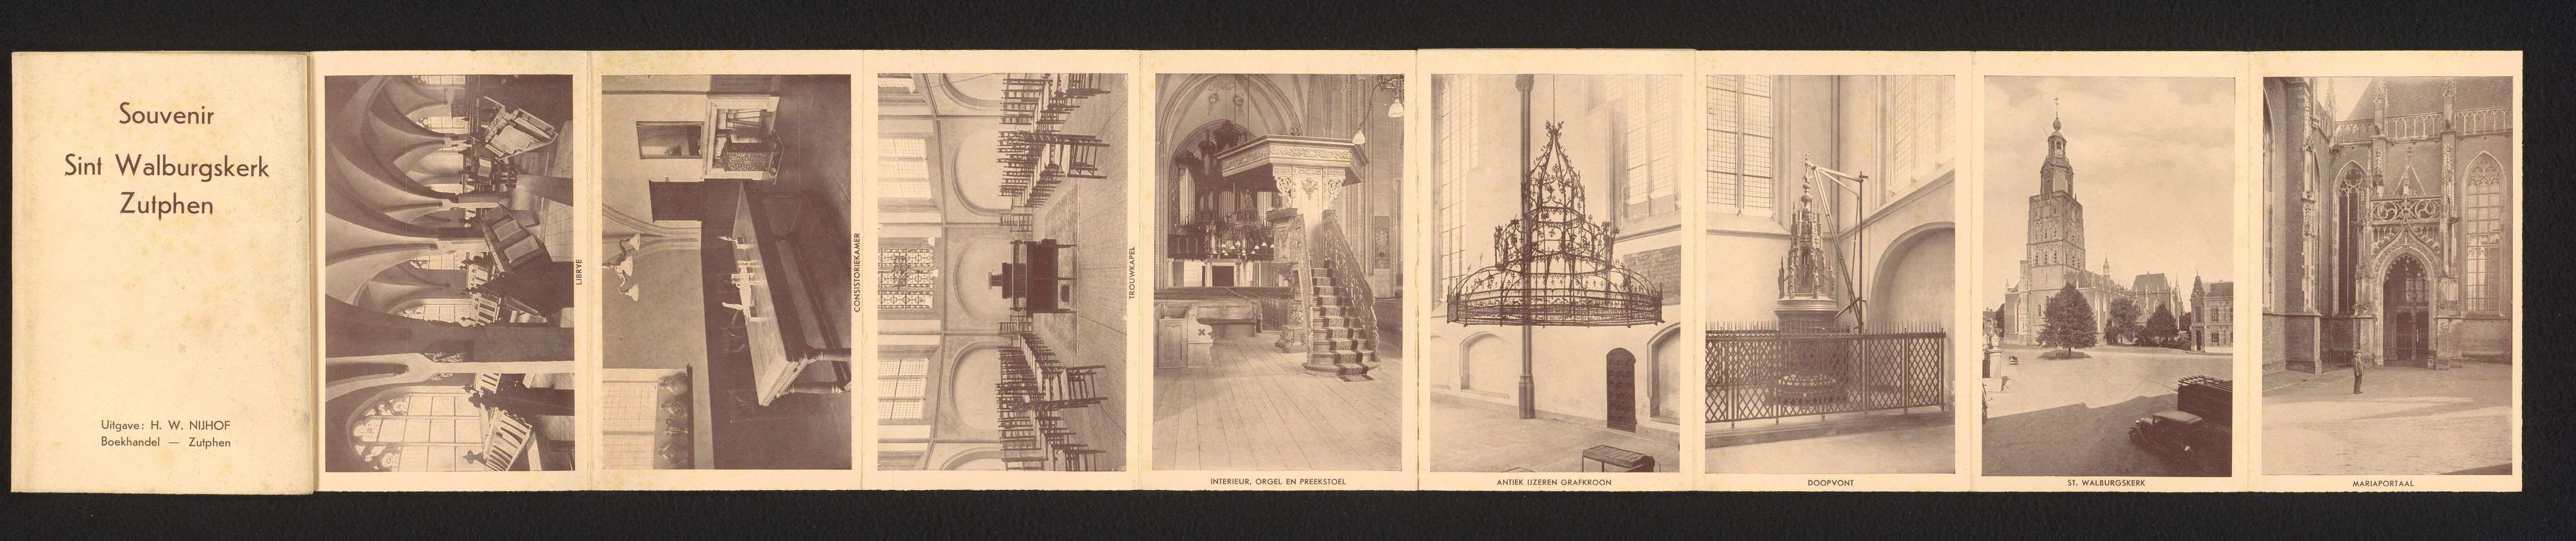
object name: accordion book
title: Souvenir. Sint Walburgskerk. Zutphen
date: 1925-1940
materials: cardboard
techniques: autotype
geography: zutphen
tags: church (exterior)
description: Leporelloalbum met acht prentbriefkaarten.